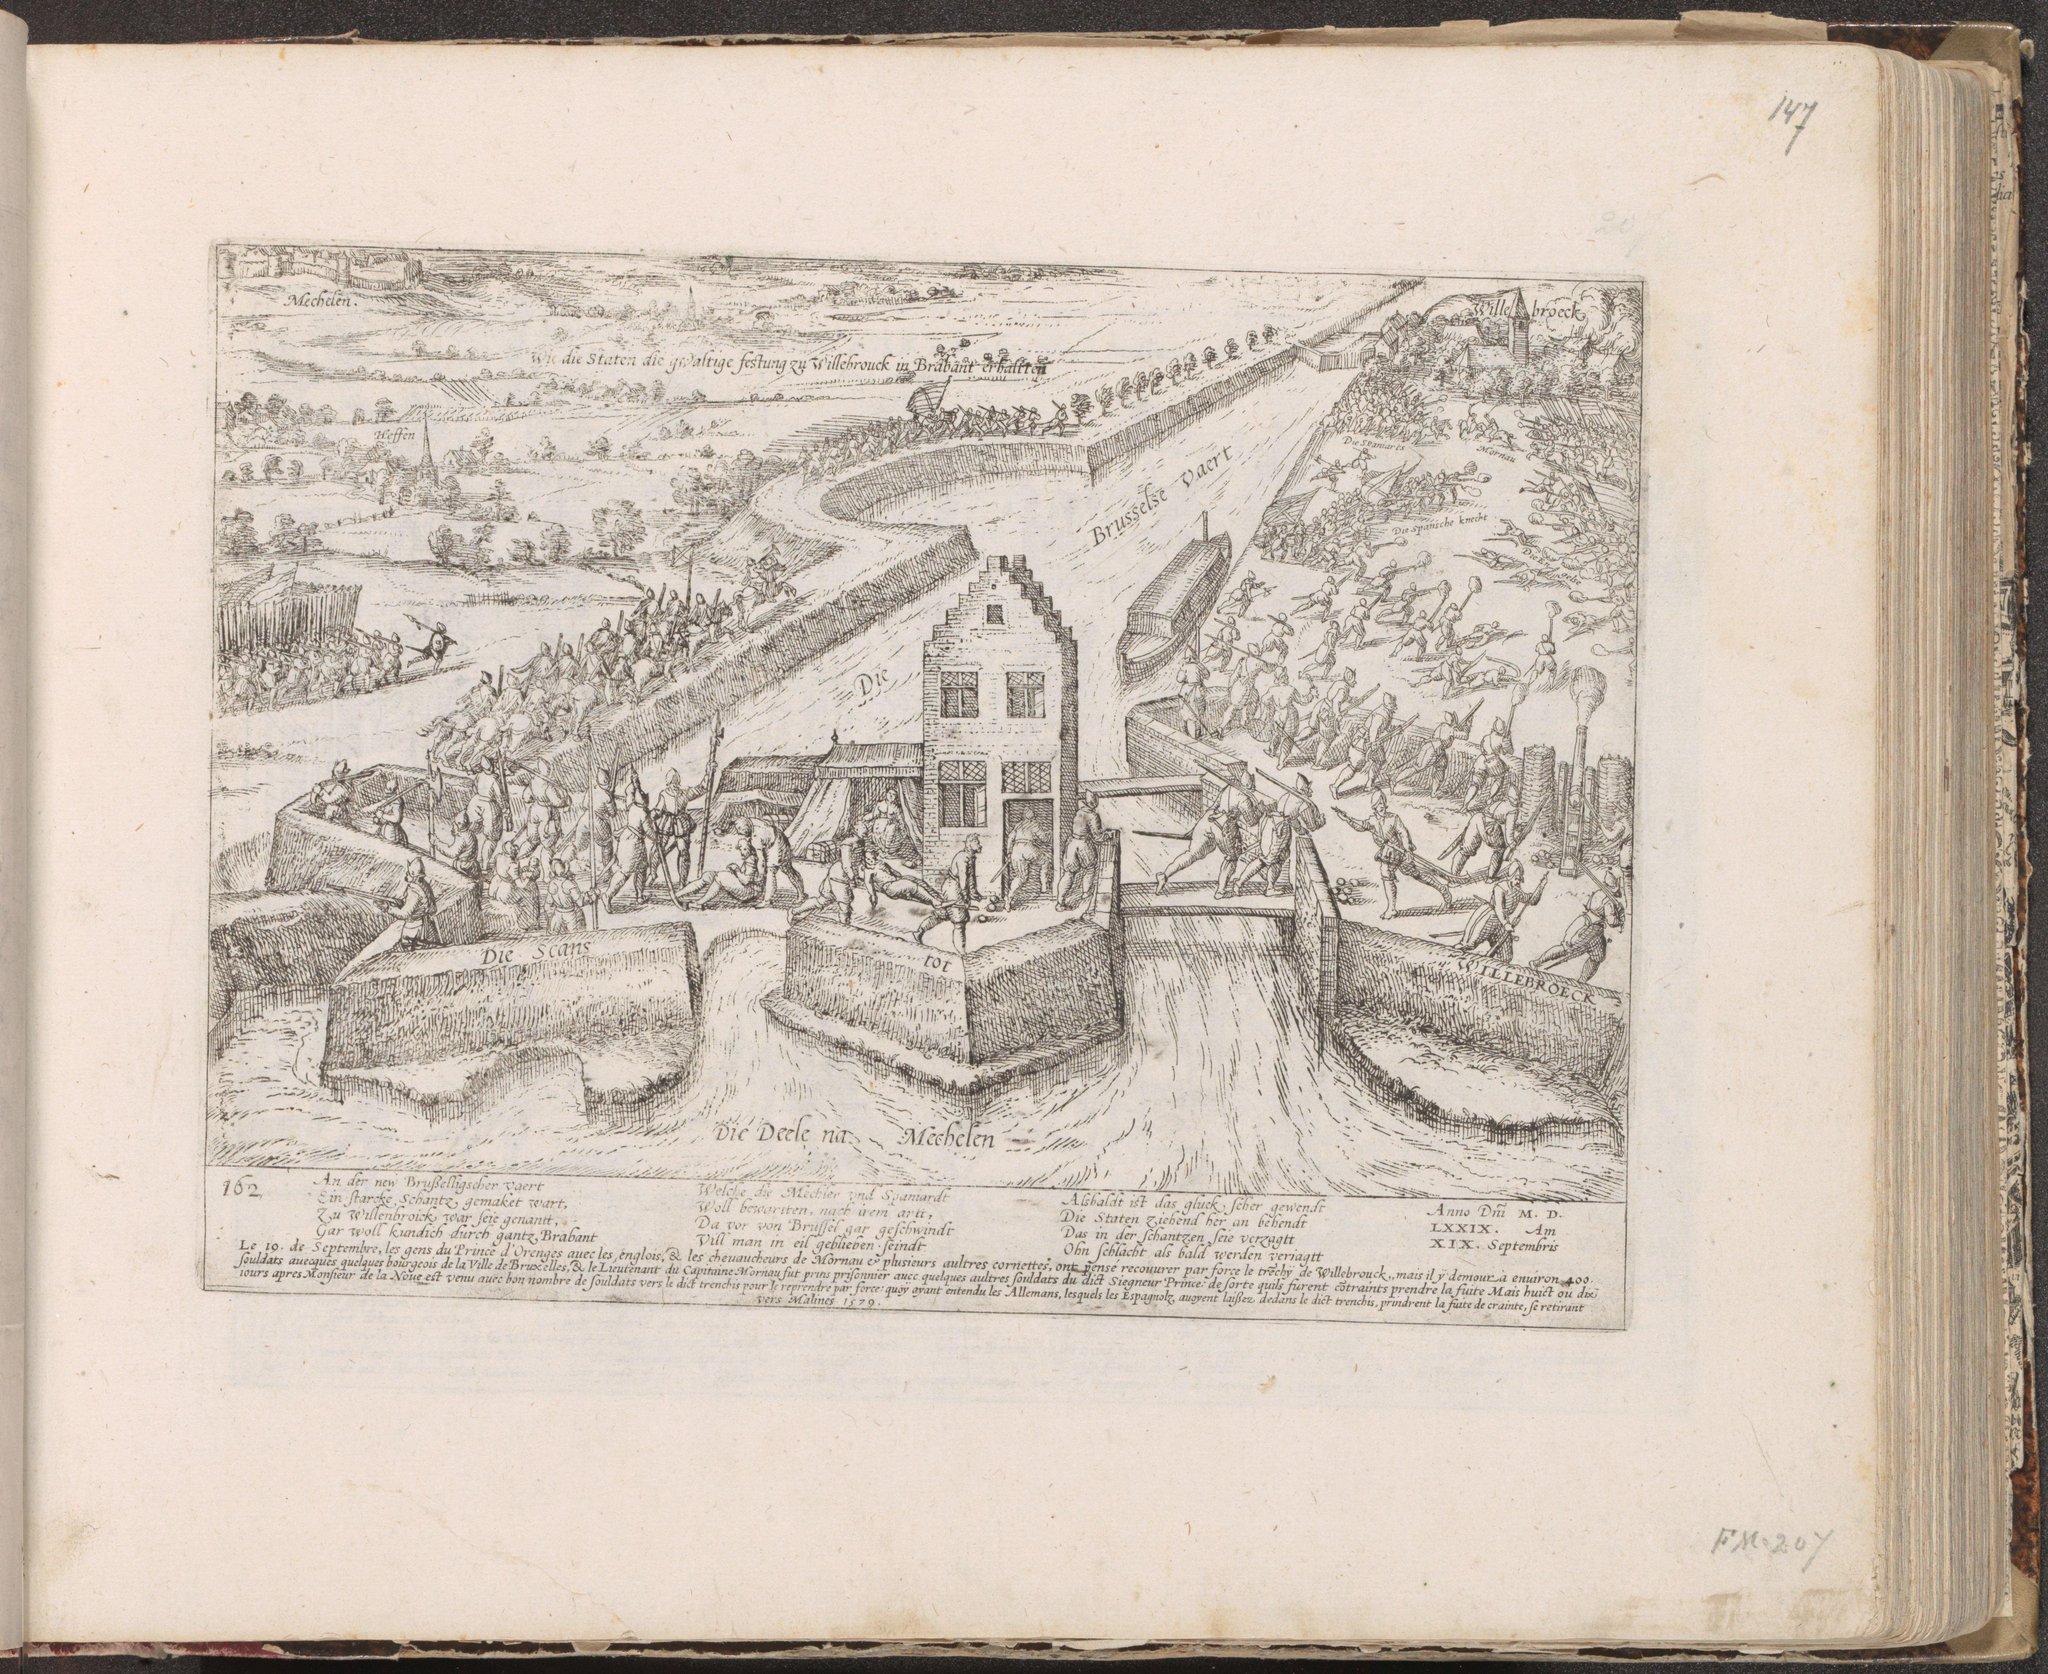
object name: print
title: Wie die Staten die gwaltige festung zu Willebrouck in Brabant erhaltten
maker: frans hogenberg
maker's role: print maker, publisher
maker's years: 1538-1590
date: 1581-1585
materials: paper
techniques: etching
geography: cologne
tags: capture of city (after the siege)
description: Verovering van de schans bij de sluizen van Willebroek door de Staten, 19 september 1579. Op de voorgrond de ingenomen schans, op de achtergrond gevechten bij het plaatsje Willebroek en de Brusselse vaart. Met onderschrift van 12 regels in het Duits en 3 lange regels in het Frans. Linksonder genummerd: 162. De prent maakt deel uit van een album.